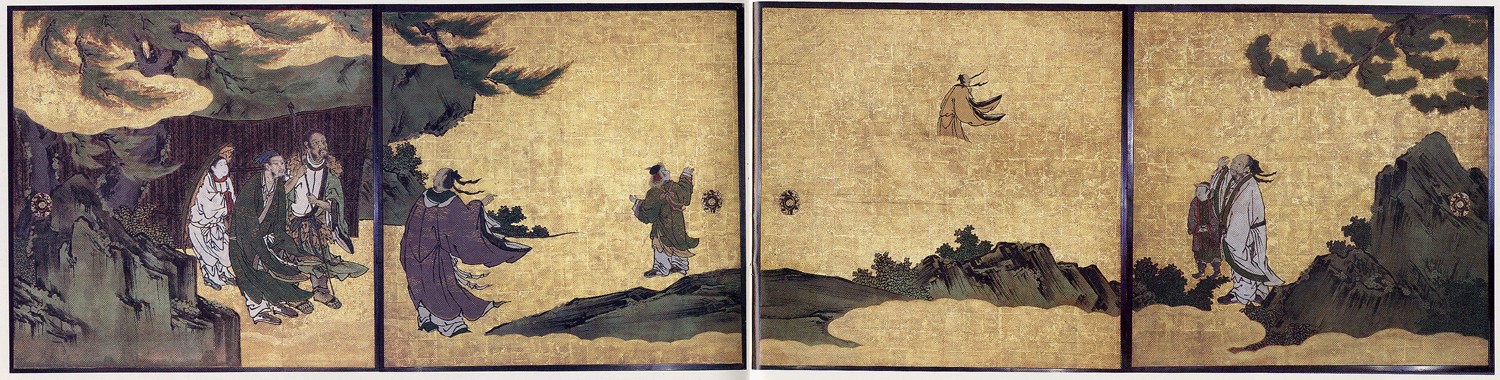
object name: door panel fusuma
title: The Daoist Immortal Liezi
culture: japanese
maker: kano school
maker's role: artist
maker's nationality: japanese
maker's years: 1476-1559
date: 1606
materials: gold, gold leaf, ink, panel, paper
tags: men,daoism